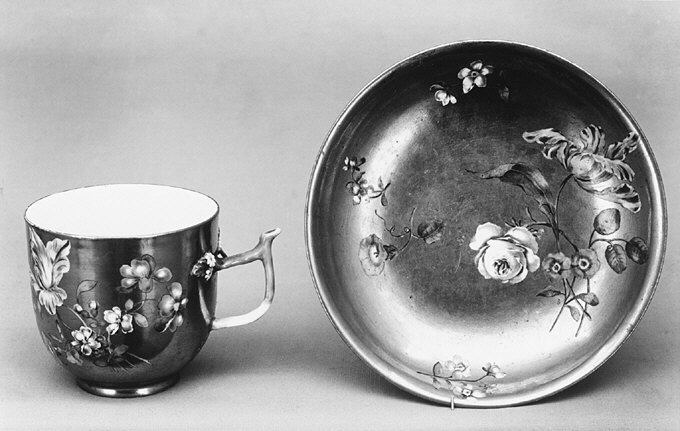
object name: saucer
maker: meissen manufactory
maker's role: manufactory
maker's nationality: german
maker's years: 1710-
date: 1701-1800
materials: hard paste porcelain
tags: flowers,roses